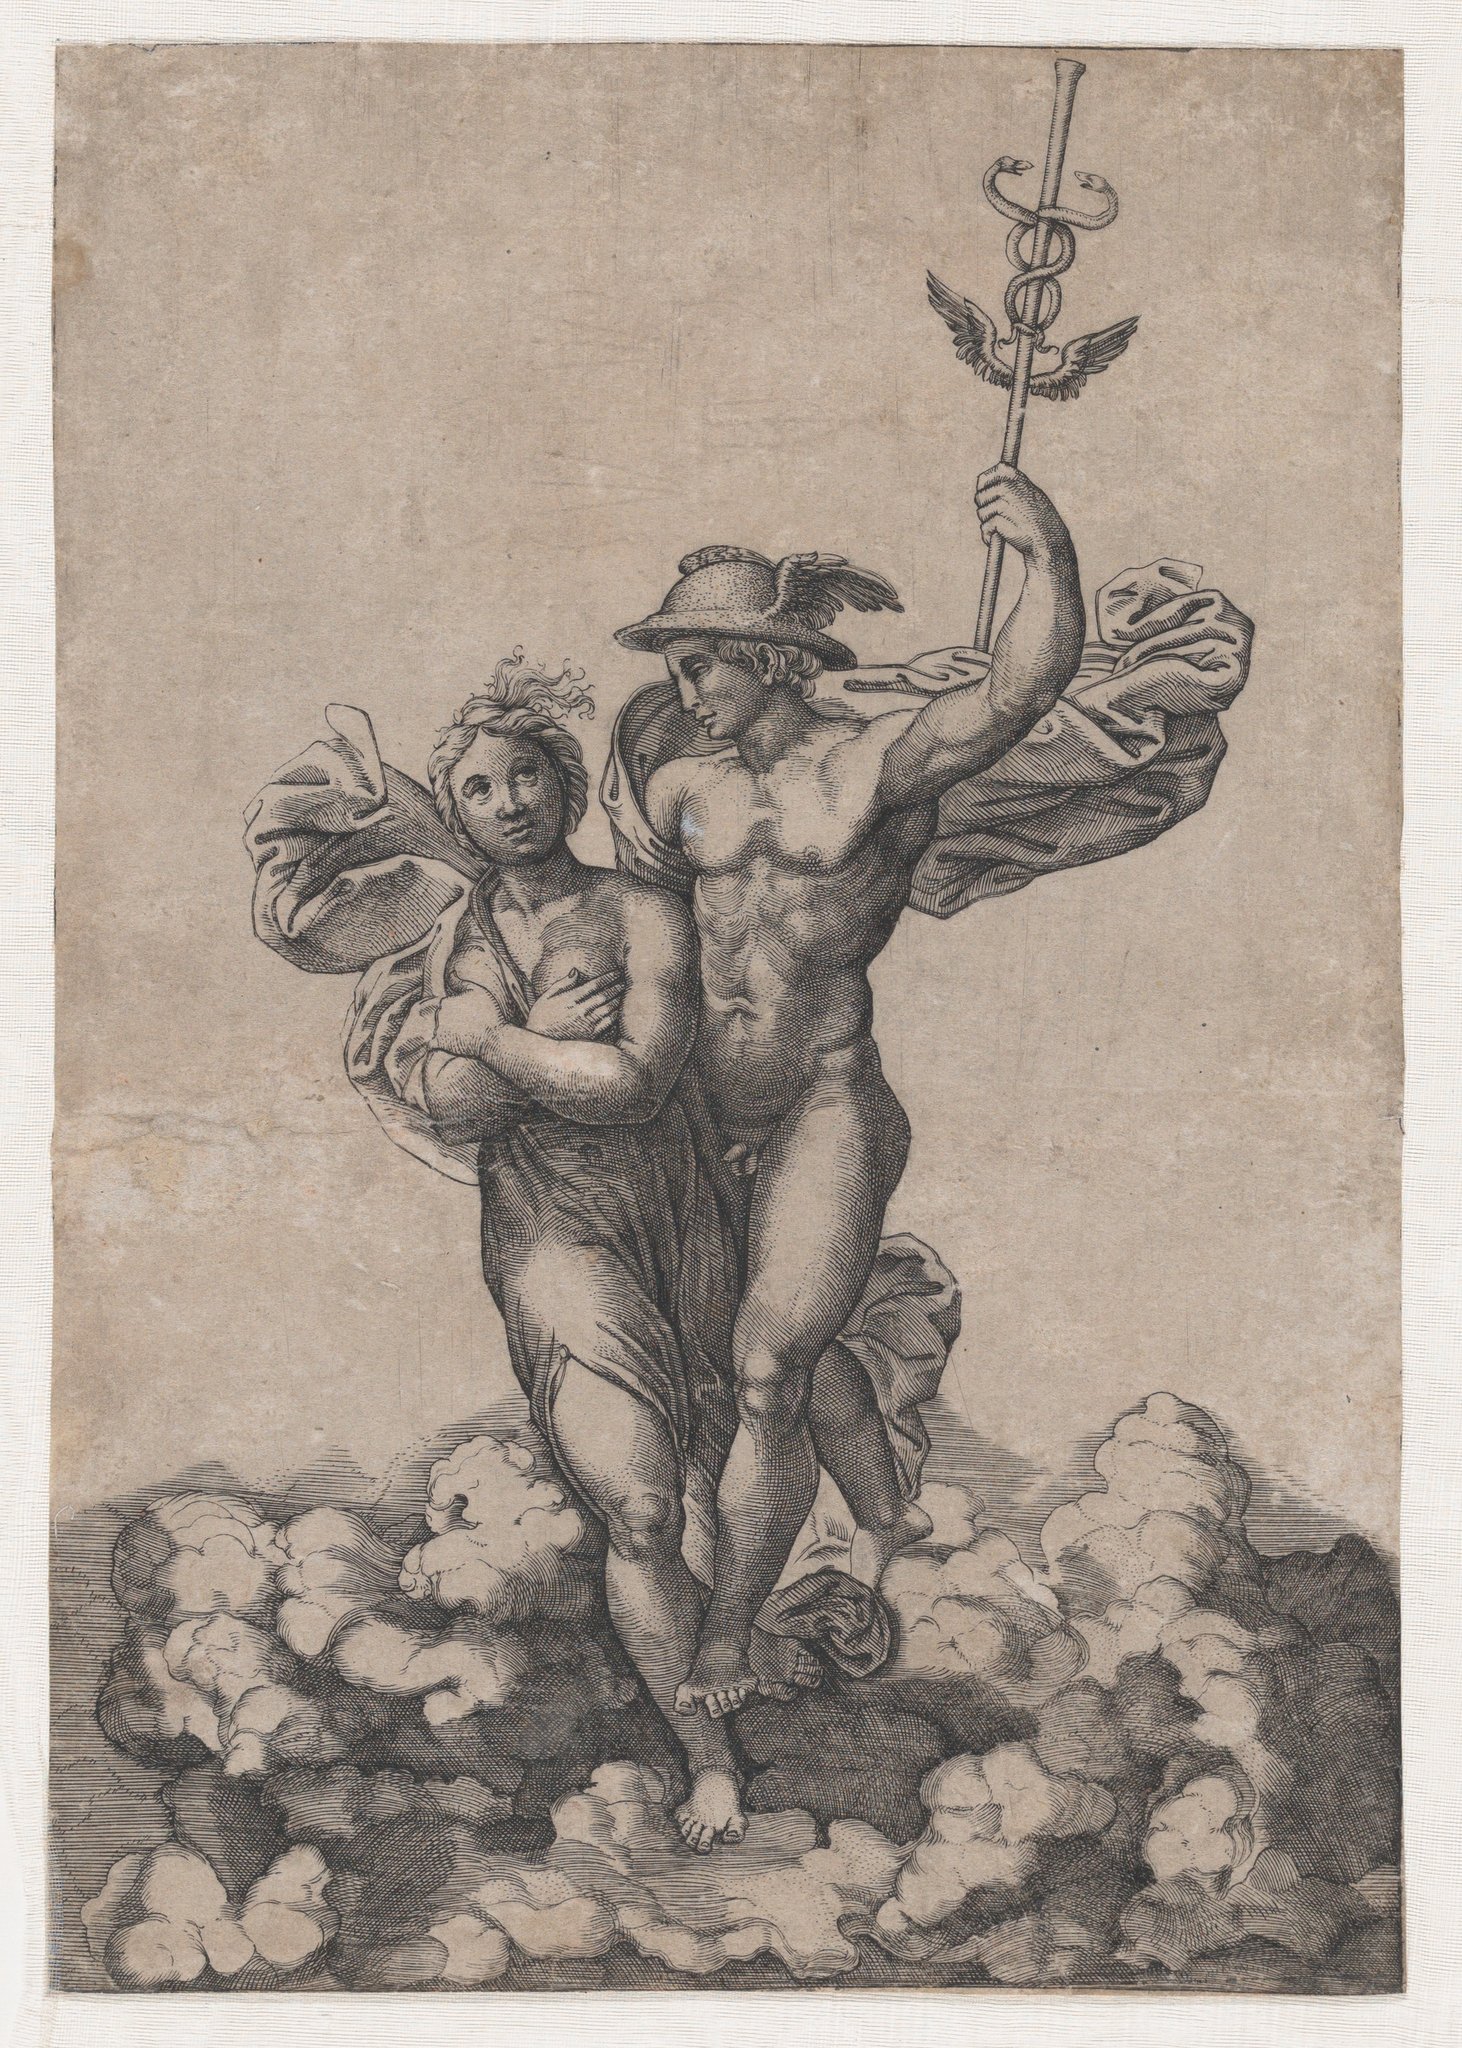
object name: print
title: Mercury carrying Psyche to Olympus, after Raphael's composition in the Villa Farnesina, Rome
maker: giovanni jacopo caraglio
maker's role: artist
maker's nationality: italian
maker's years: 1500-1565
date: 1520-1539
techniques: engraving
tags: psyche,mercury